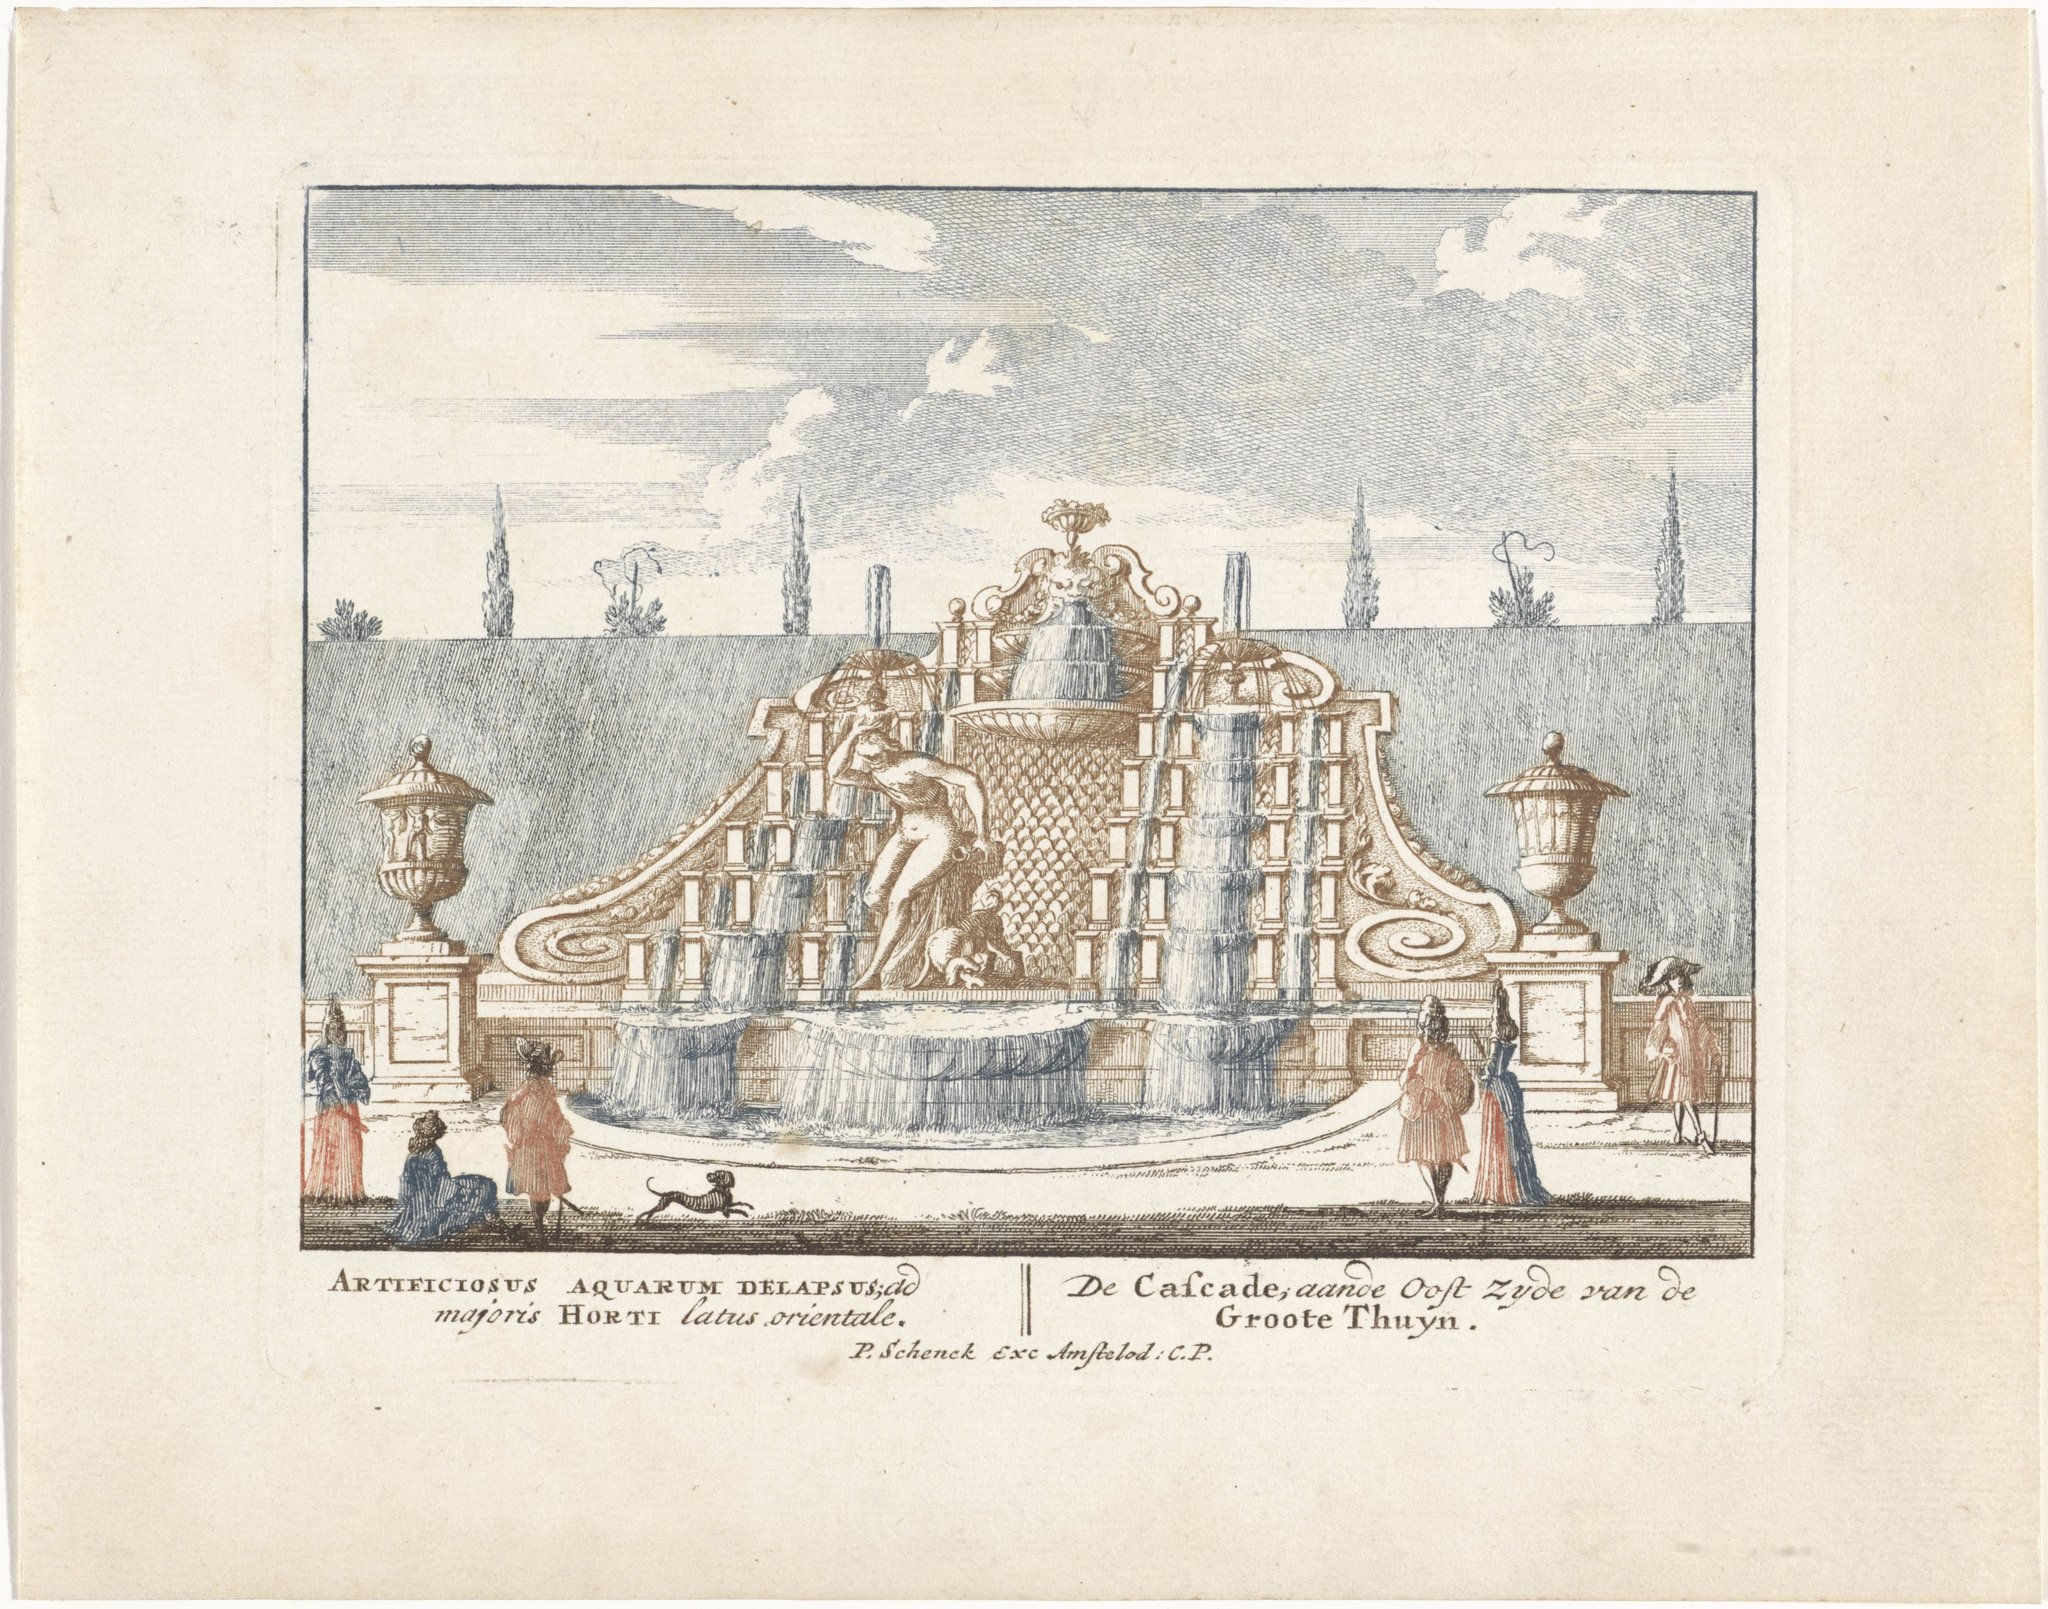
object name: print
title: Uitgeleesene Gesichte van het Wijdvermaarde Loo als andere vorstelijke Huisen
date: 1694-1697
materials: paper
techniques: etching, lithography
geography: amsterdam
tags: garden fountain, french or architectonic garden; formal garden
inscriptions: collector's mark: Lugt 2228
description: Elegant geklede dames en heren verpozen zich bij de grote fontein aan de oostzijde van de grote tuin van Het Loo. Prent uit een serie van 71 prenten met Rijnlandschappen, gezichten op vorstelijke paleizen en stadsgezichten uit Den Haag en Amsterdam.